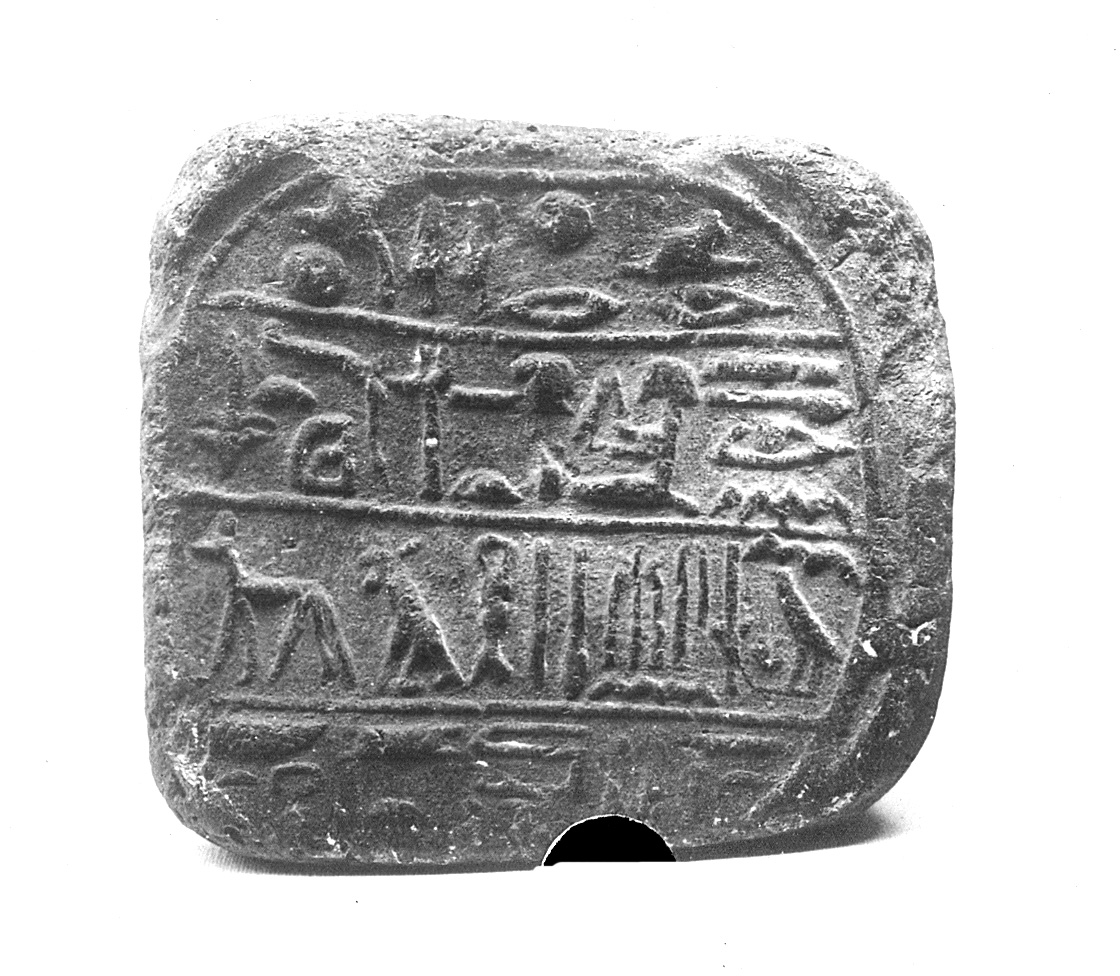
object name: cone, userhat, harim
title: Funerary Cone of Userhat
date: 1550-1295 BCE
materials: pottery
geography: egypt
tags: hieroglyphs